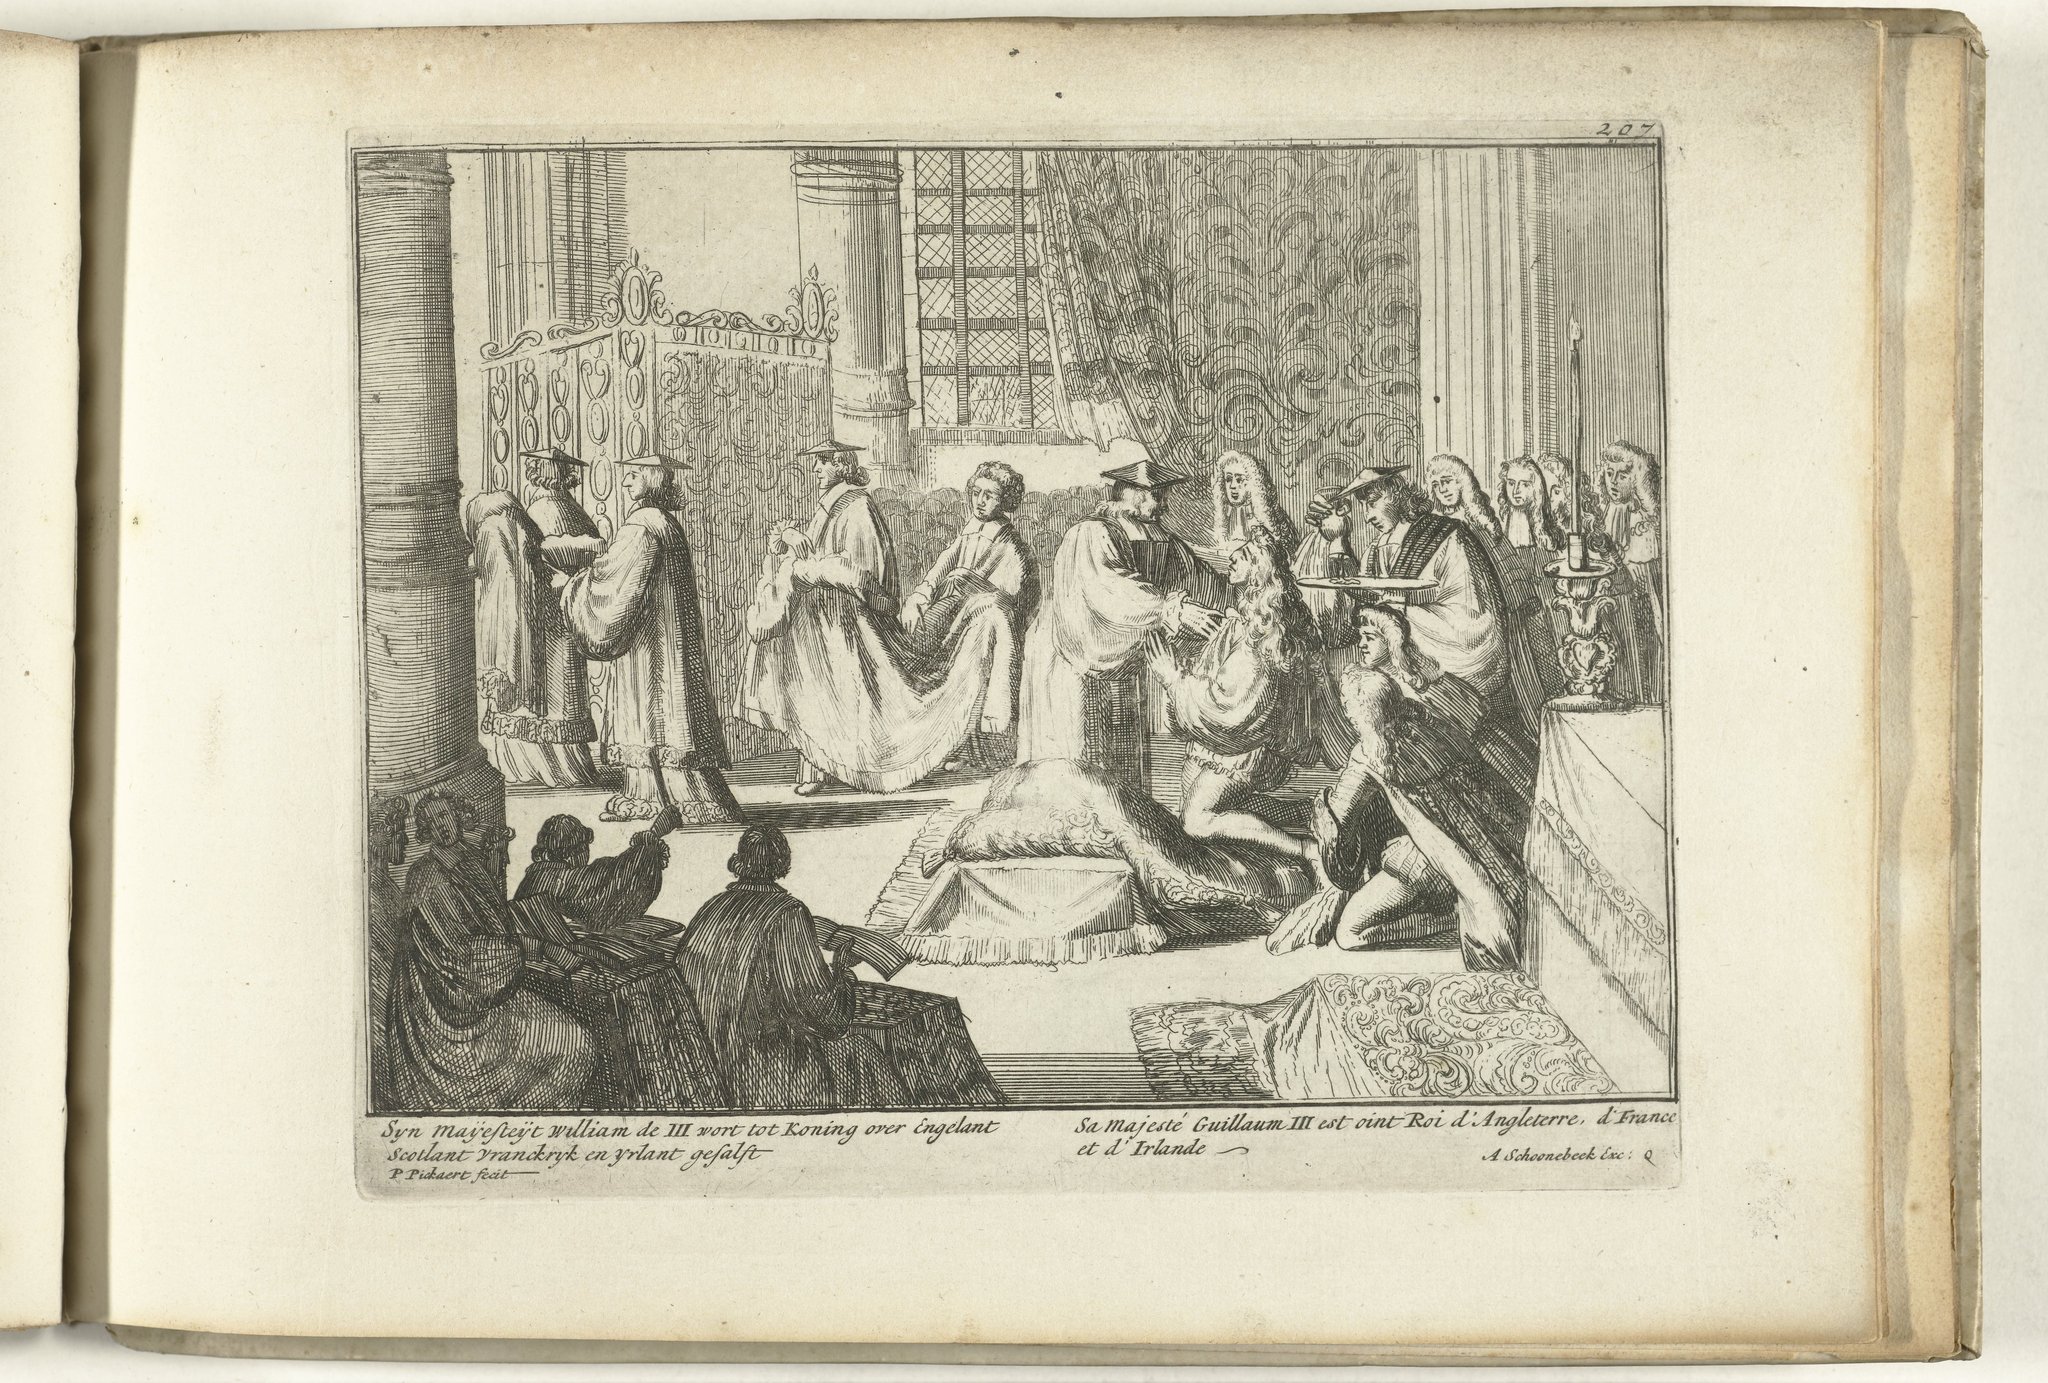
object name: print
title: Syn Mayesteyt William de III wort tot Koning over Engelant Scotlant Vranckryk en Yrlant gesalft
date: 1689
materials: paper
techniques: etching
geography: amsterdam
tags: the hague, william iii (prince of orange and king of england, scotland, and ireland), anointing the ruler (during coronation), westminster abbey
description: Willem III wordt knielend tot de nieuwe koning van Engeland gezalft, 21 april 1689. Genummerd rechtsboven: 207. Plaat Q in de serie 'Engelants schouwtoneel' over de Glorious Revolution 1688-1689 (tweede deel). Met onderschriften in het Nederlands en Frans.